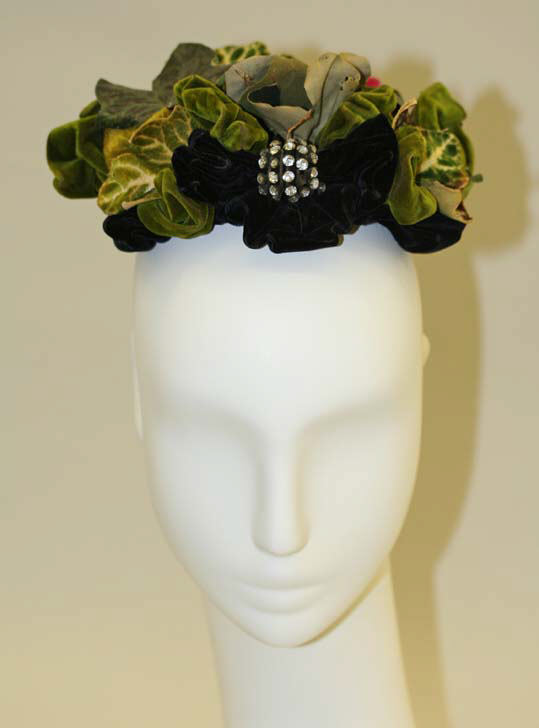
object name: hat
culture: american or european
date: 1891